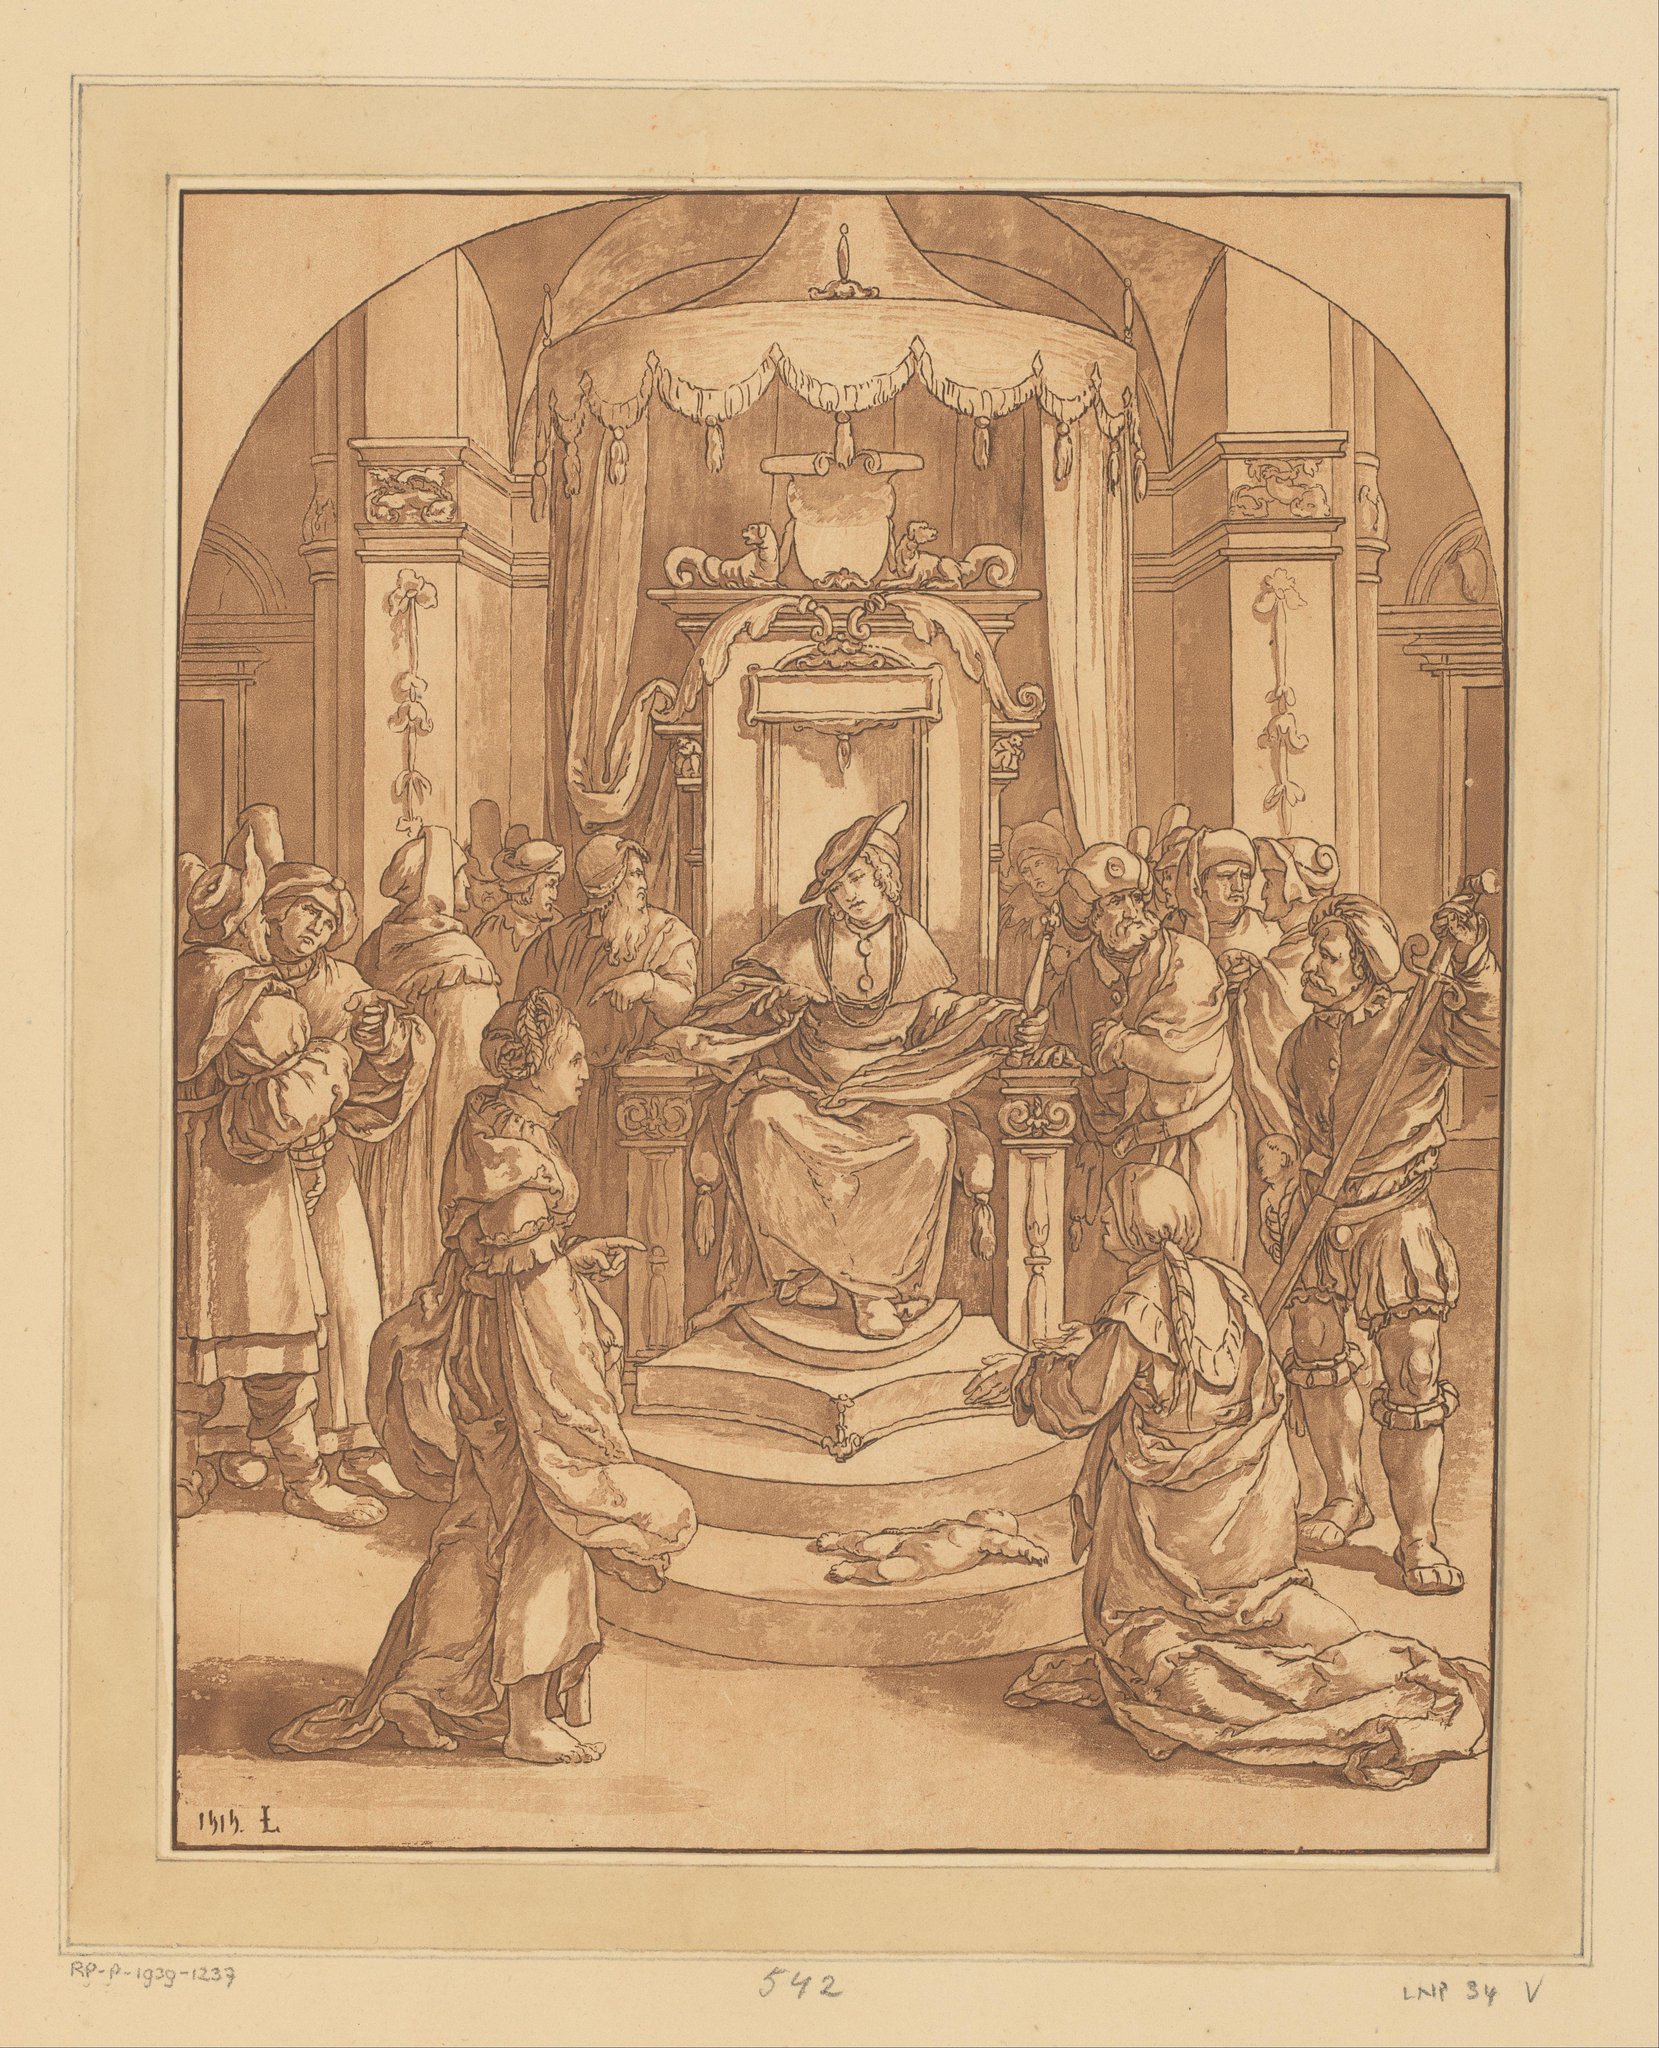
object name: print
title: Oordeel van Salomo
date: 1782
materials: paper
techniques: etching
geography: amsterdam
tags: the judgement of solomon (1 kings 3:16-28)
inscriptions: collector's mark: ‘RIJKS / MUSM’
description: Koning Salomo zit op zijn troon en velt zijn oordeel. Hij geeft de opdracht om de baby in tweeën te laten delen om te bepalen wie de moeder van het kind is. Rechts trekt een man zijn zwaard. Voor de troon de twee vrouwen die beiden het moederschap van het kind claimen. De prent ligt los in een album, zie blad 34.